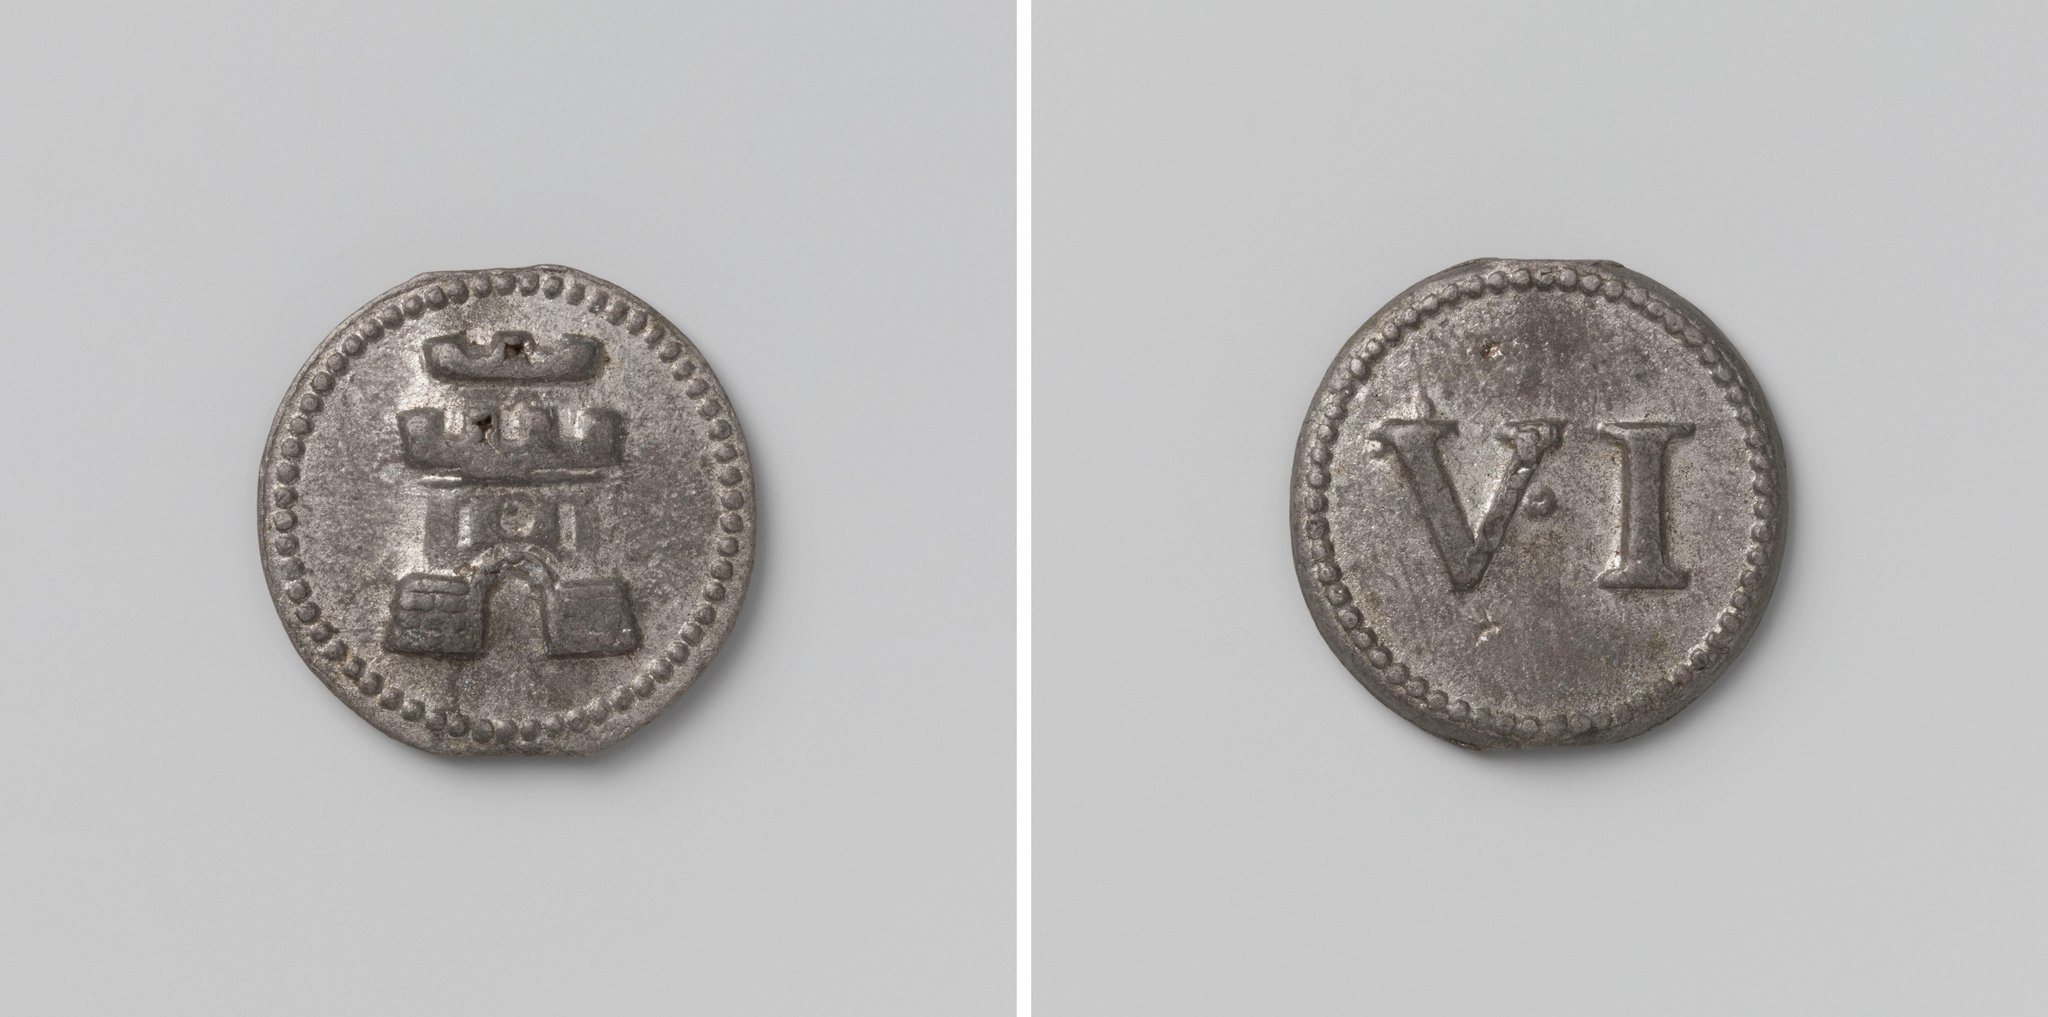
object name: monetary token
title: Zes stuiver, betaalpenning van de Vroedschap van Middelburg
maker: Anonymous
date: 1672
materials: alloy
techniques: striking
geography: middelburg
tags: middelburg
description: Penning. Voorzijde: burcht binnen parelrand. Keerzijde: Romeins cijfer VI